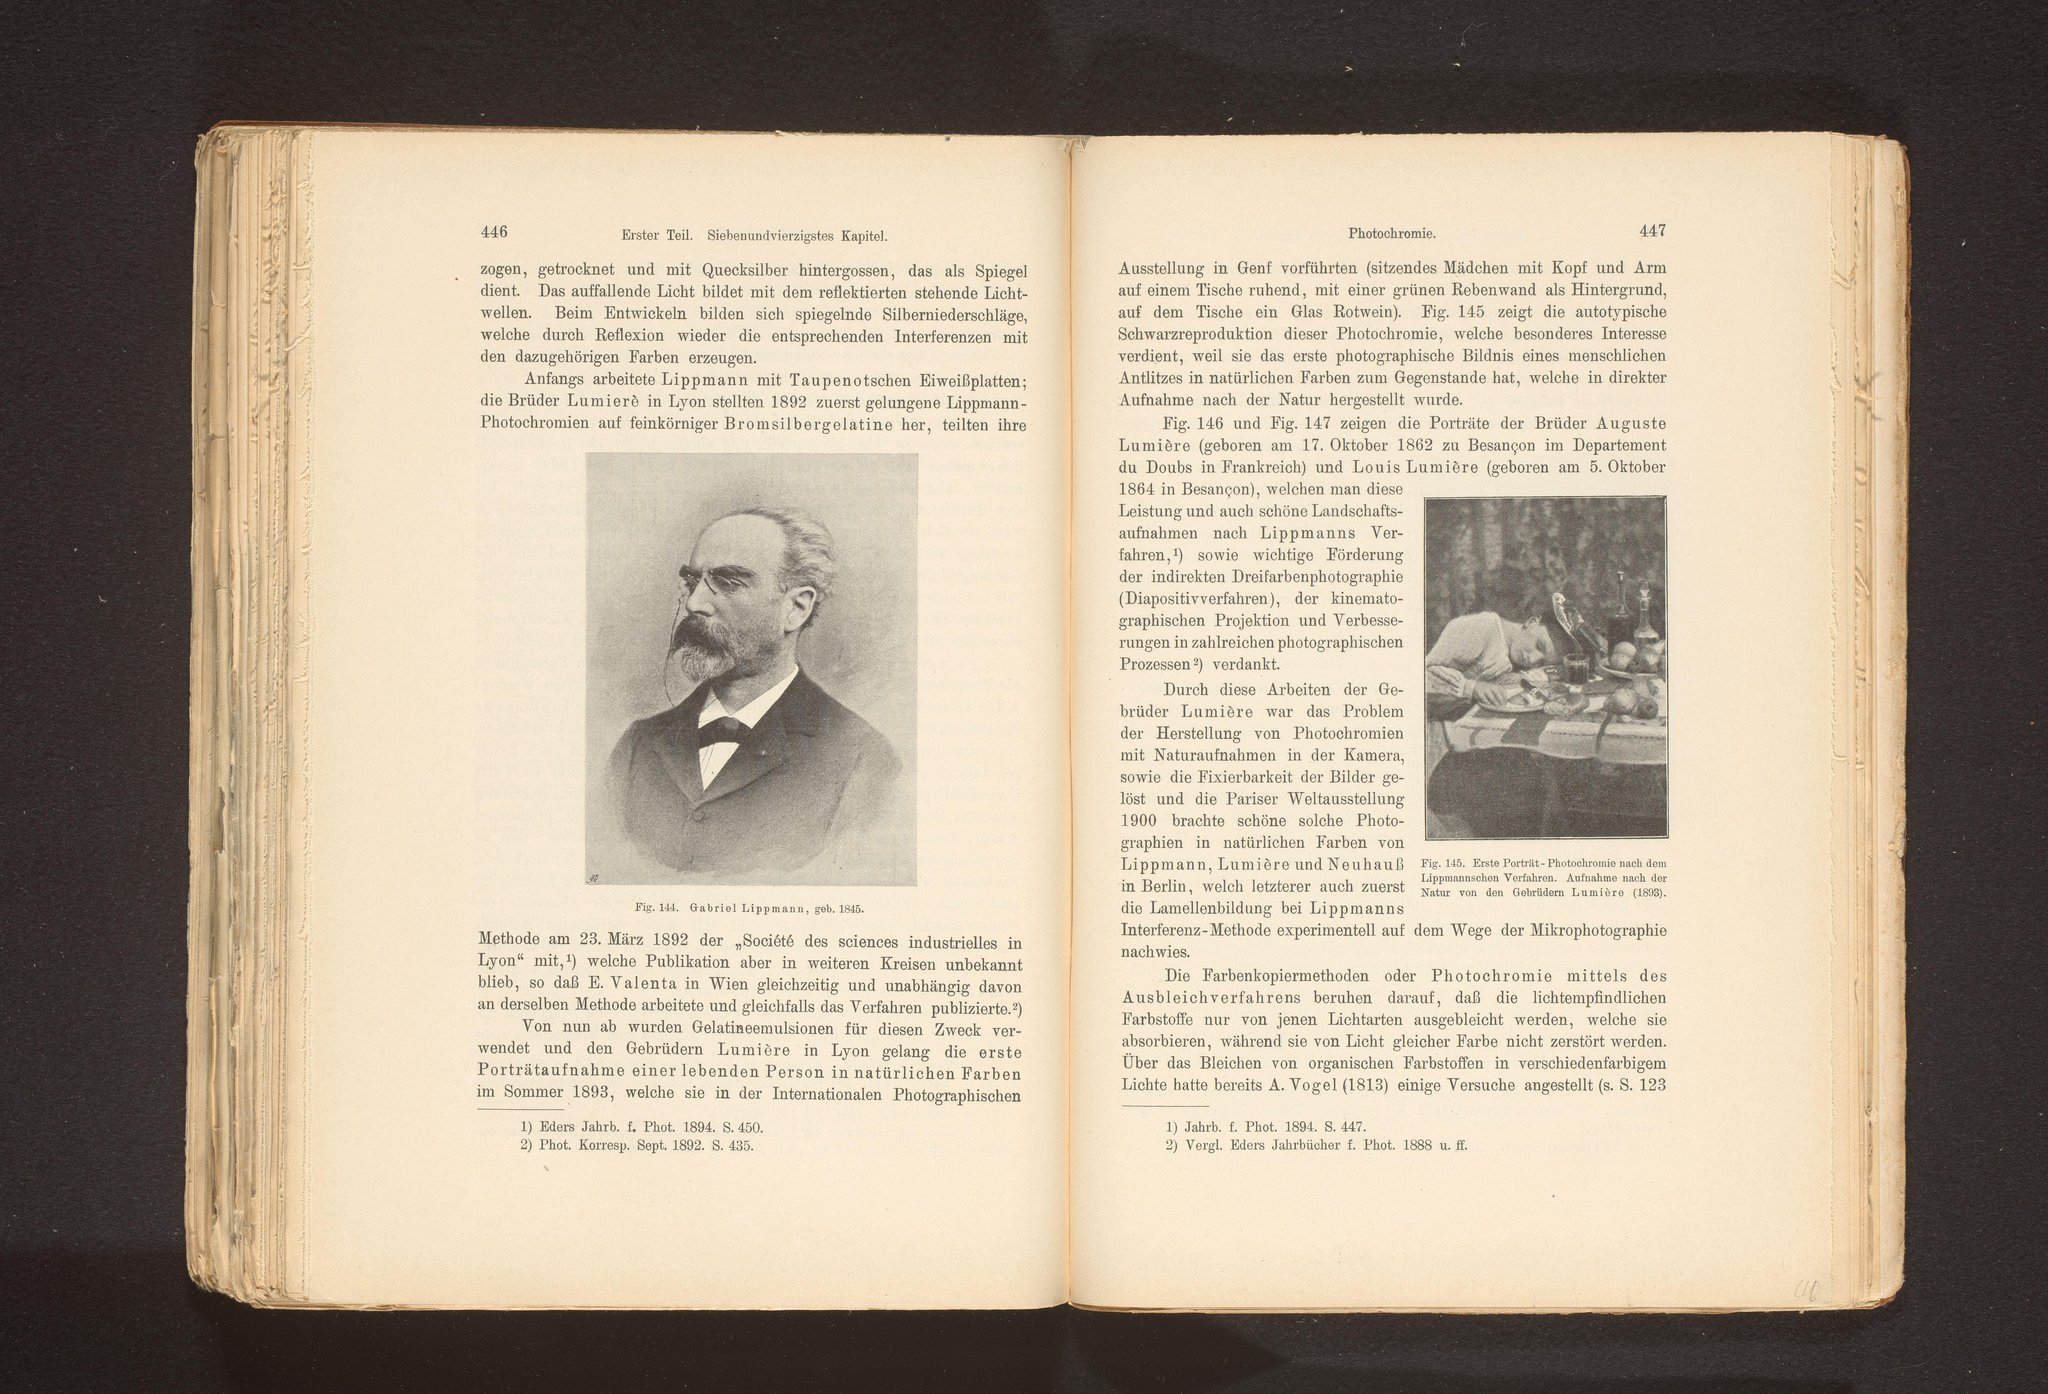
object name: photomechanical print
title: Slapende vrouw aan een eettafel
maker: Anonymous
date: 1900-1905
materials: paper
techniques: autotype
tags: adult woman, table, sleeping; unconsciousness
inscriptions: number: ‘Fig. 145.’, inscription: ‘Erste Porträt- (...) Gebrüdern Lumière (1893).’